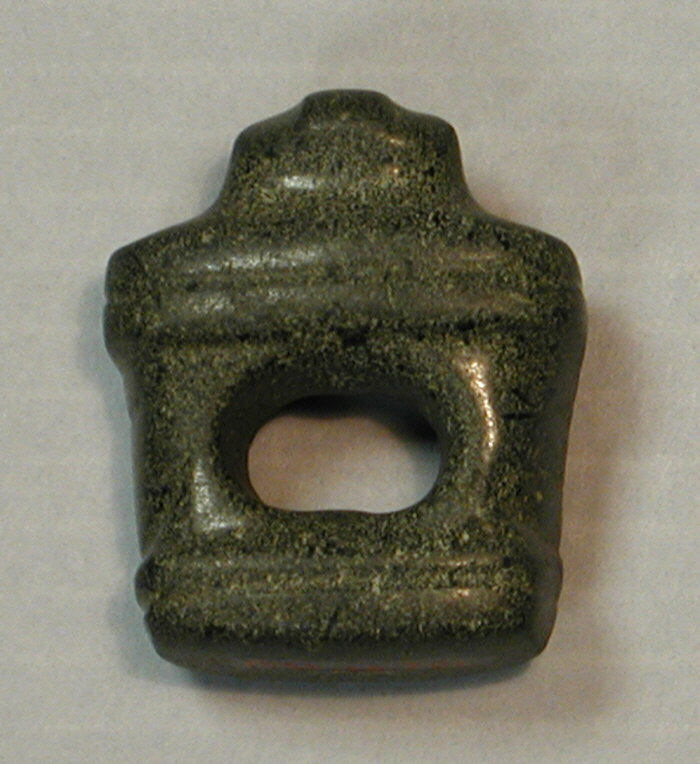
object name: architectural model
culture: mezcala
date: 1-800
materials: stone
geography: mexico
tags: temples